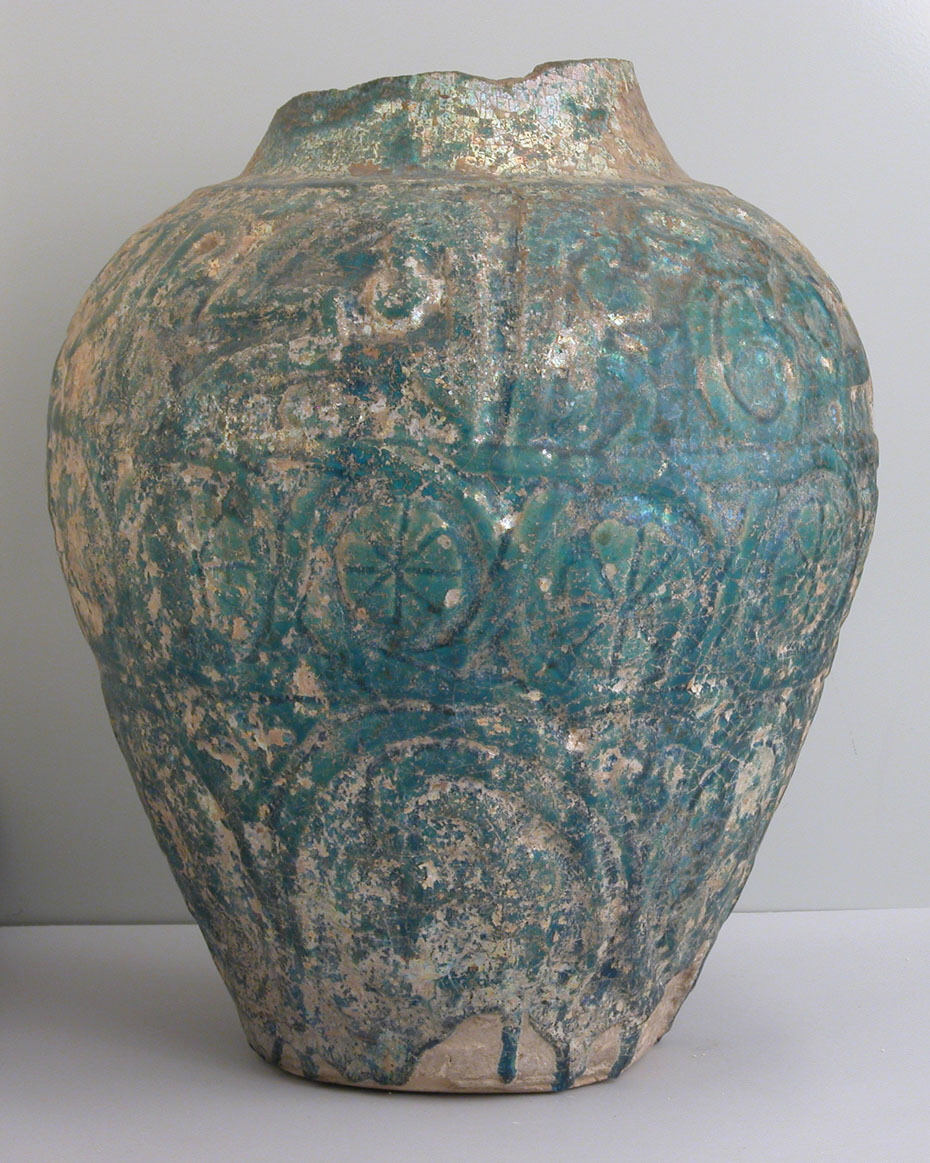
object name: jar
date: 1101-1200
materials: earthenware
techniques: glazing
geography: syria